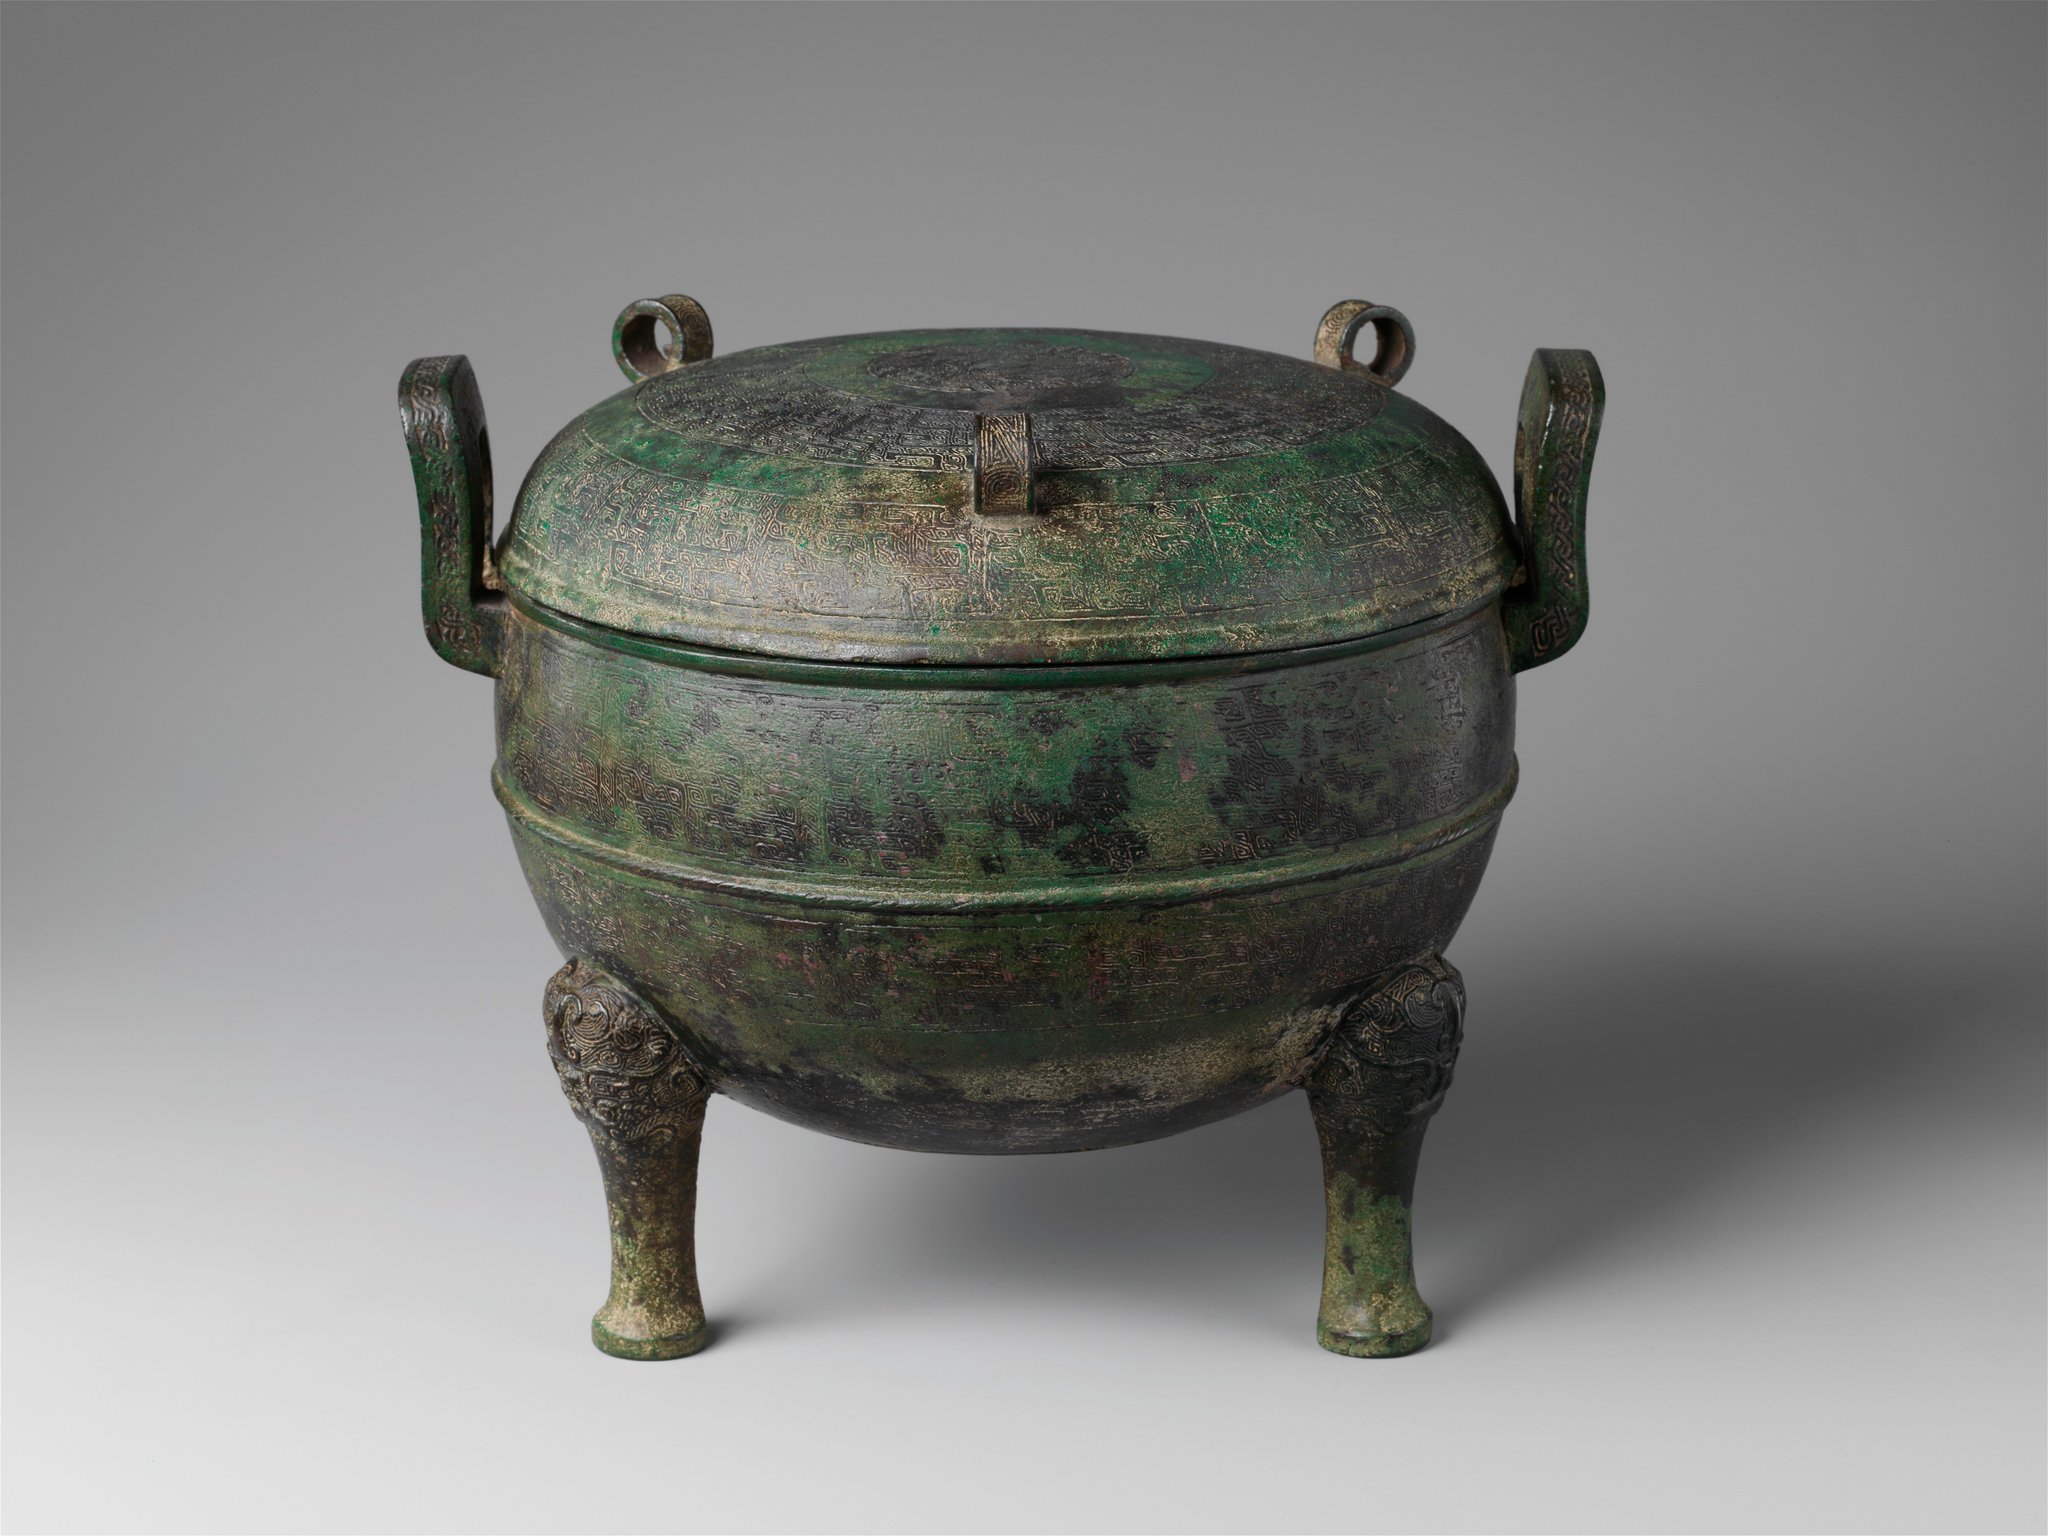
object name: tripod cauldron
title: Ritual tripod cauldron with cover (Ding)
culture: chinese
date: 500-301 BCE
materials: bronze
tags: cauldrons